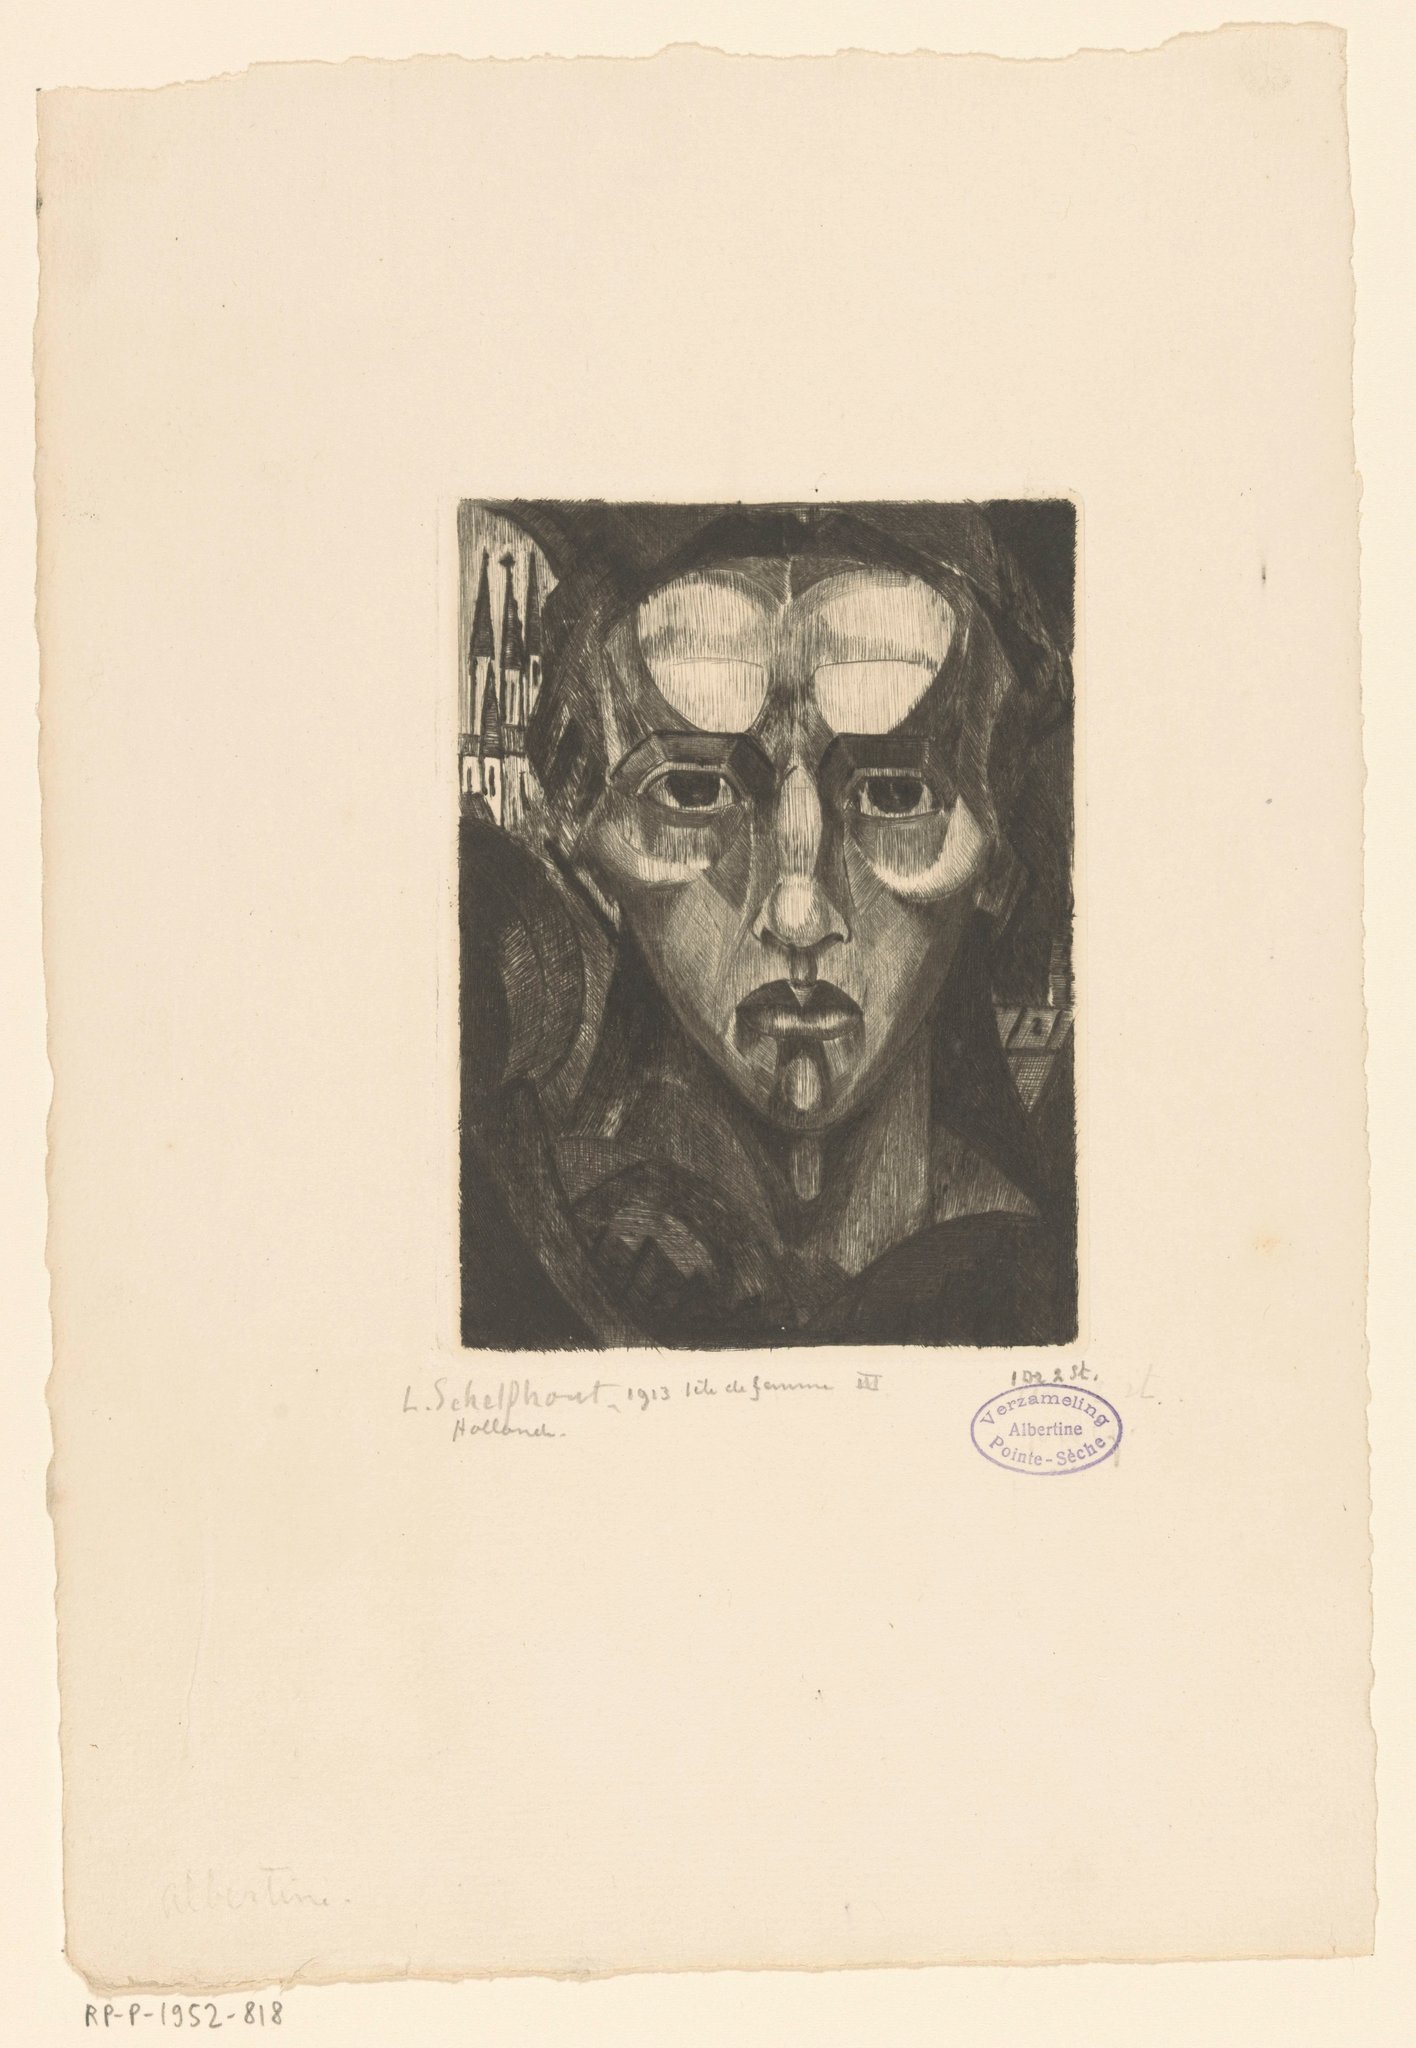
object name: print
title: Tête de femme III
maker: lodewijk schelfhout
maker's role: draughtsman, print maker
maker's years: 1881-1943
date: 1913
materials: paper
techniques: drypoint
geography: netherlands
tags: head (human) - aa - female human figure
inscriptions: collector's mark: Lugt 2760, collector's mark: Lugt 5i, collector's mark: Lugt 2228